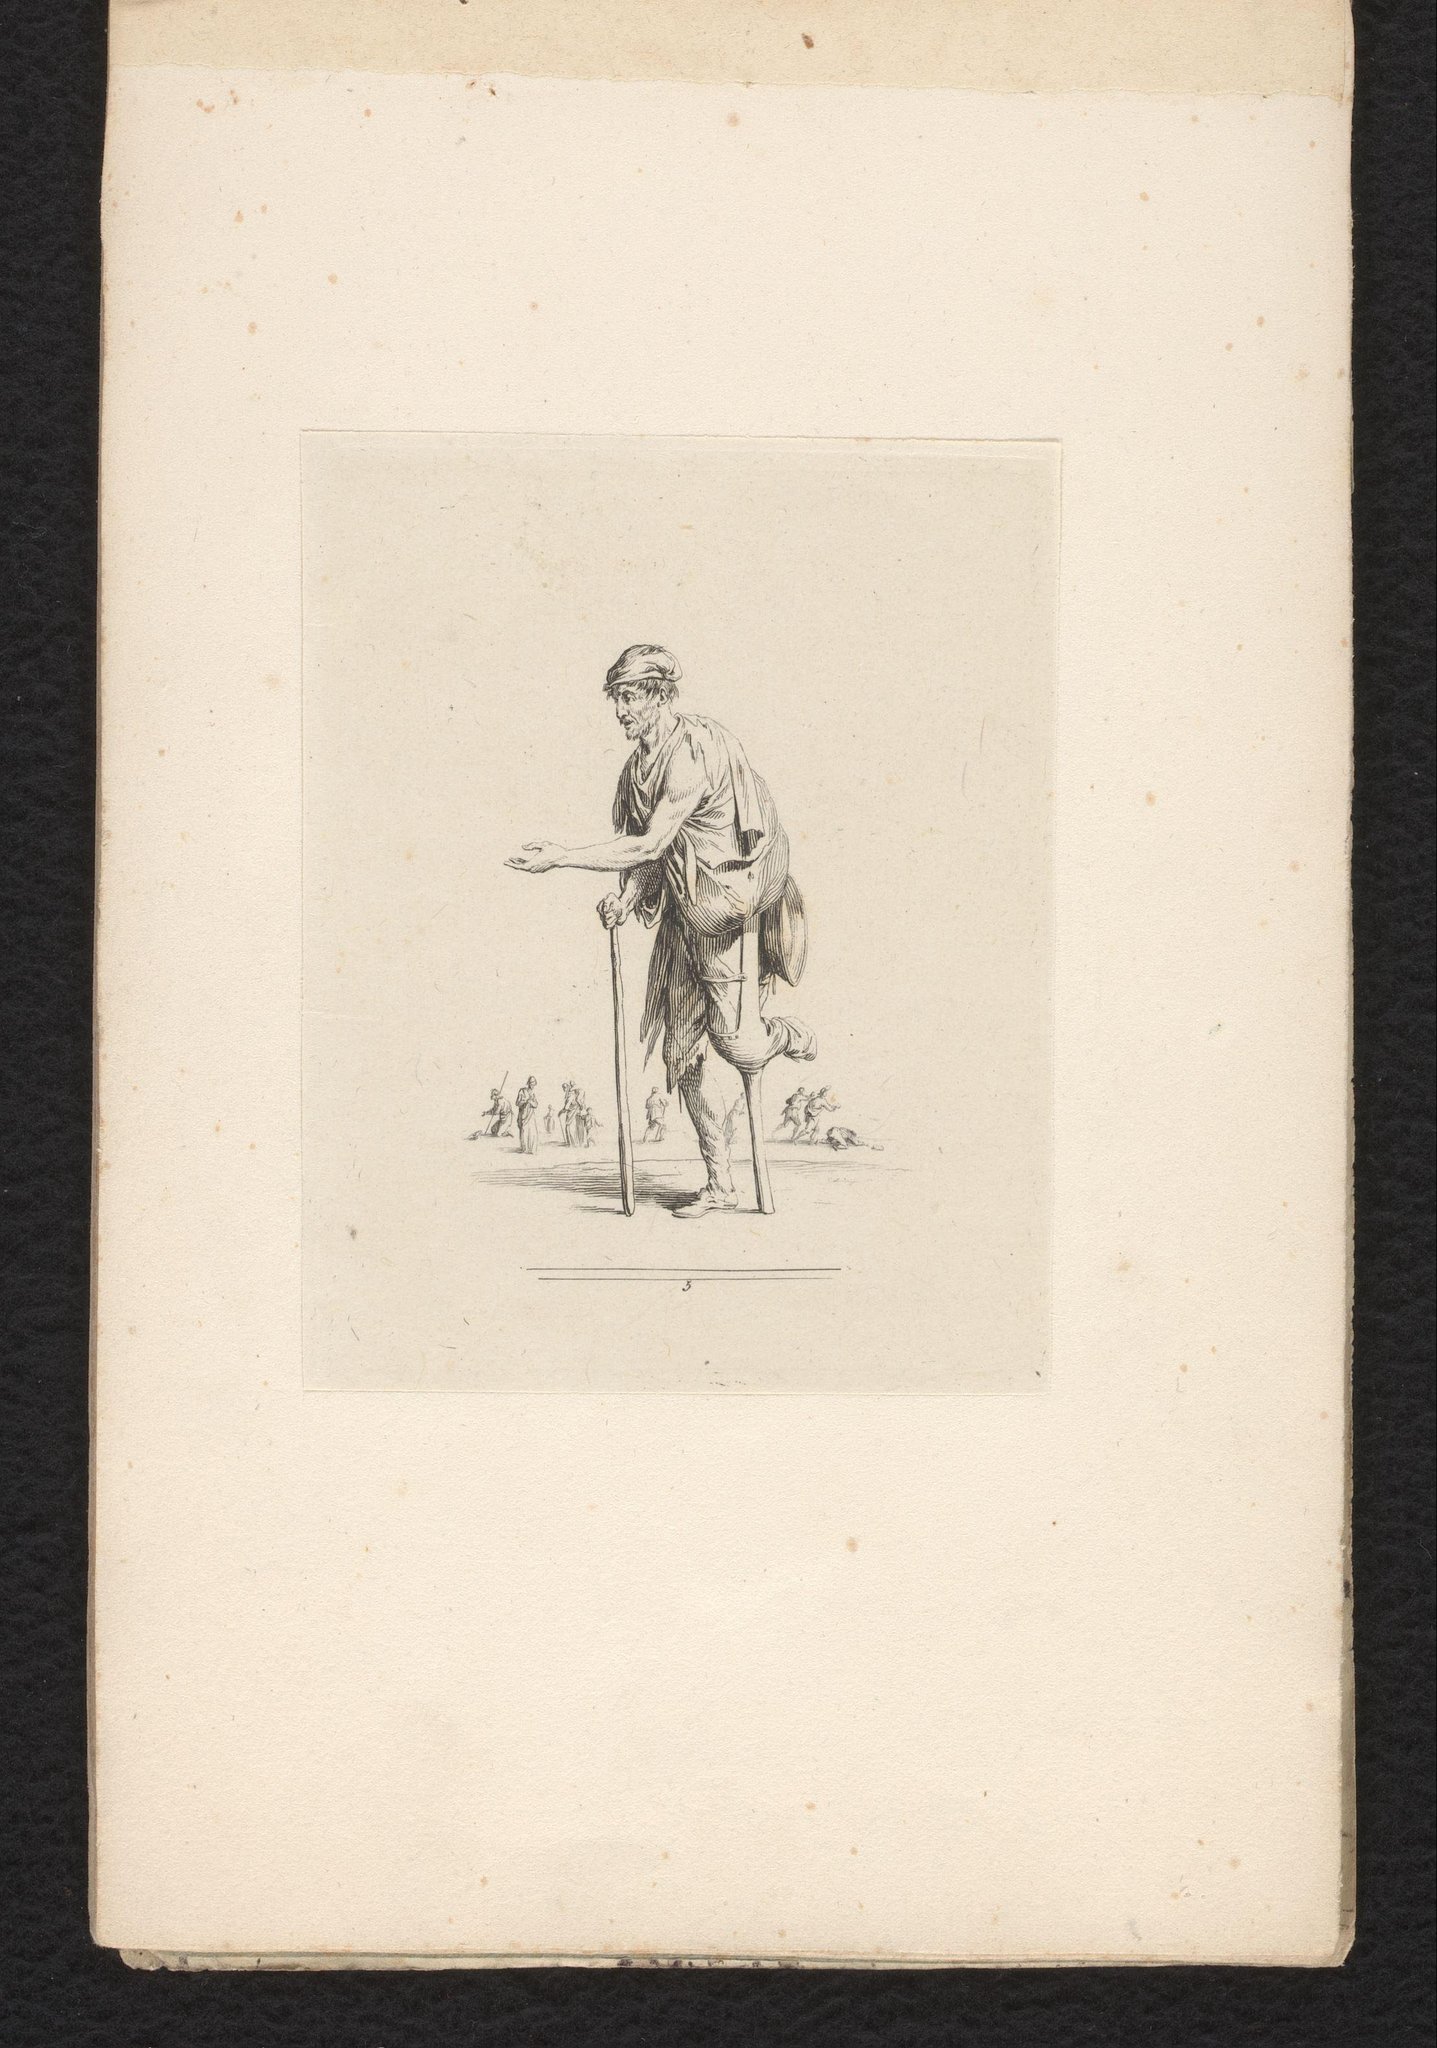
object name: print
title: Bedelaars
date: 1798-1806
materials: paper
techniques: etching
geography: paris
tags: clothed in rags, person with a physical disability, beggar